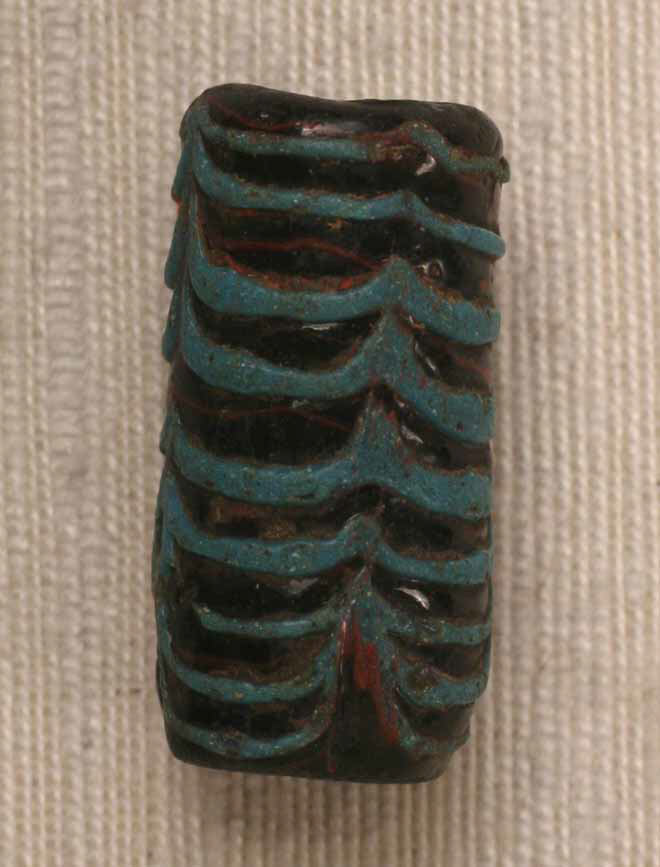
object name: bead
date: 201-1200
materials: glass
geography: egypt